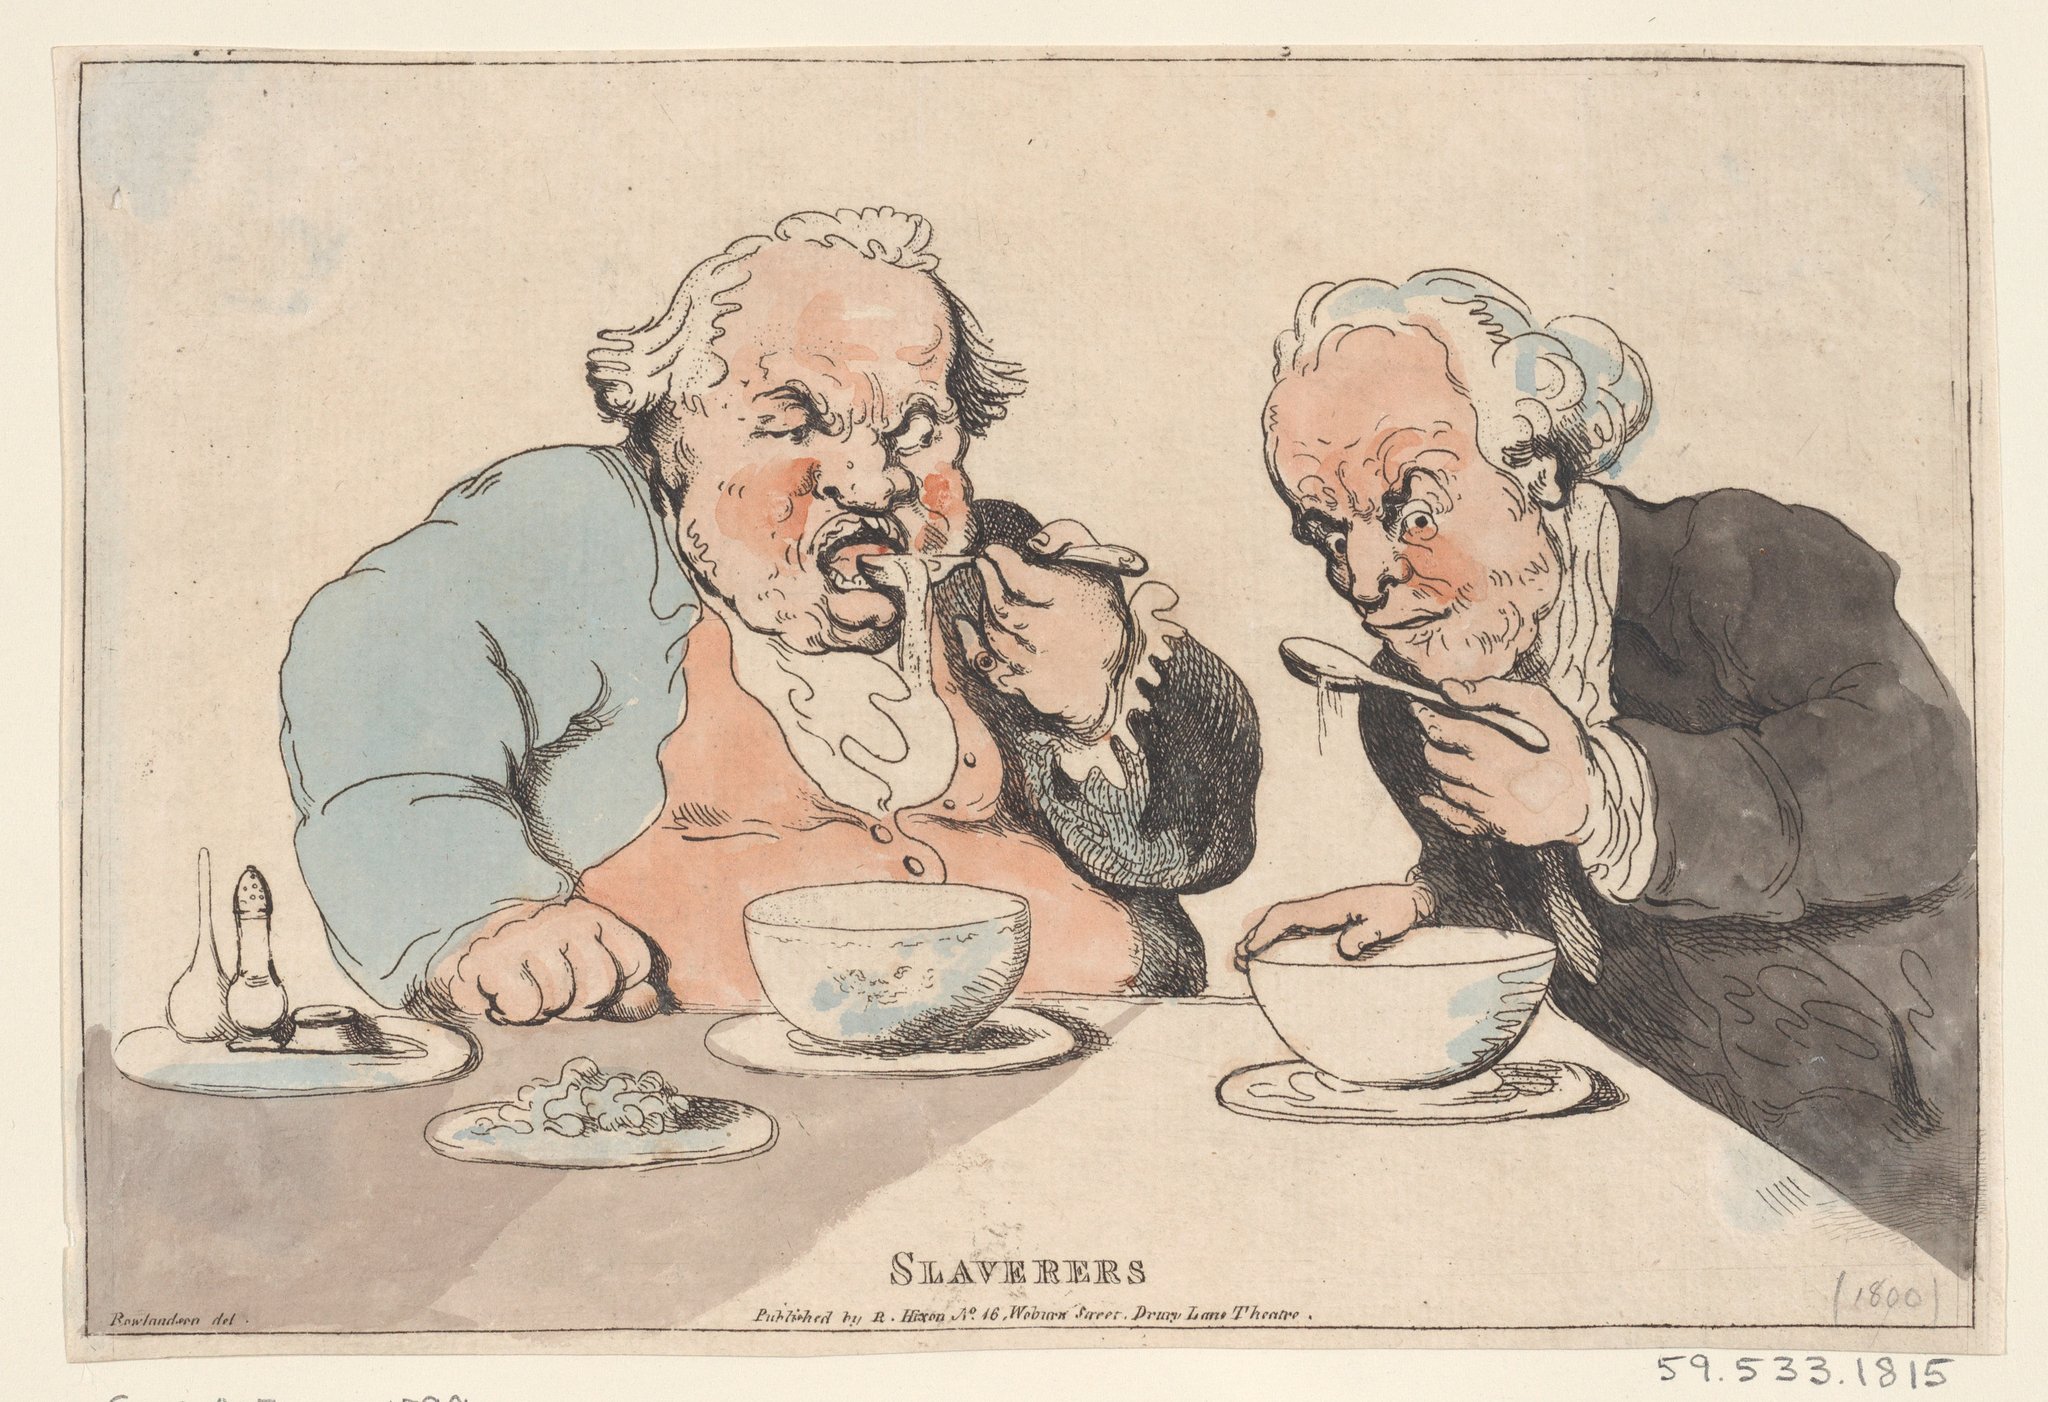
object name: print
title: Slaverers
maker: thomas rowlandson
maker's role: artist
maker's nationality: british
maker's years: 1757-1827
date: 1799-1800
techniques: etching, hand coloring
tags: men